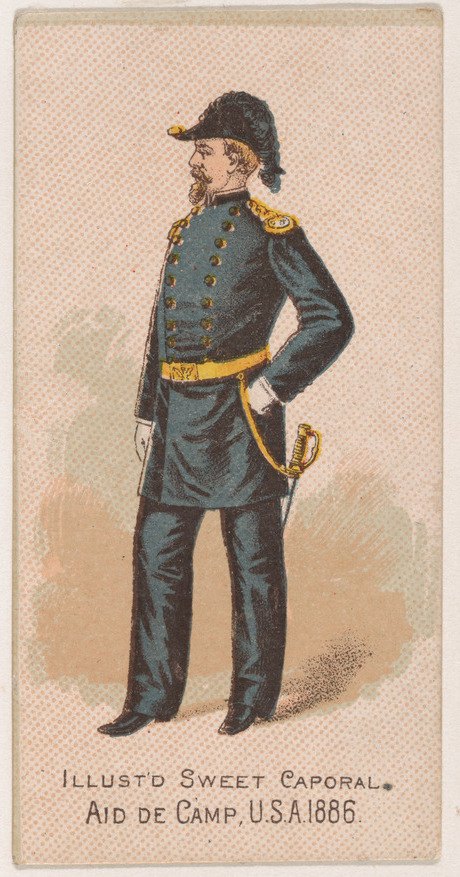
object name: print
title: Aid de Camp, United States Army, 1886, from the Military Series (N224) issued by Kinney Tobacco Company to promote Sweet Caporal Cigarettes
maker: kinney brothers tobacco company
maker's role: publisher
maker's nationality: american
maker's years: 1869-2011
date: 1888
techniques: color lithograph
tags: army,men,profiles